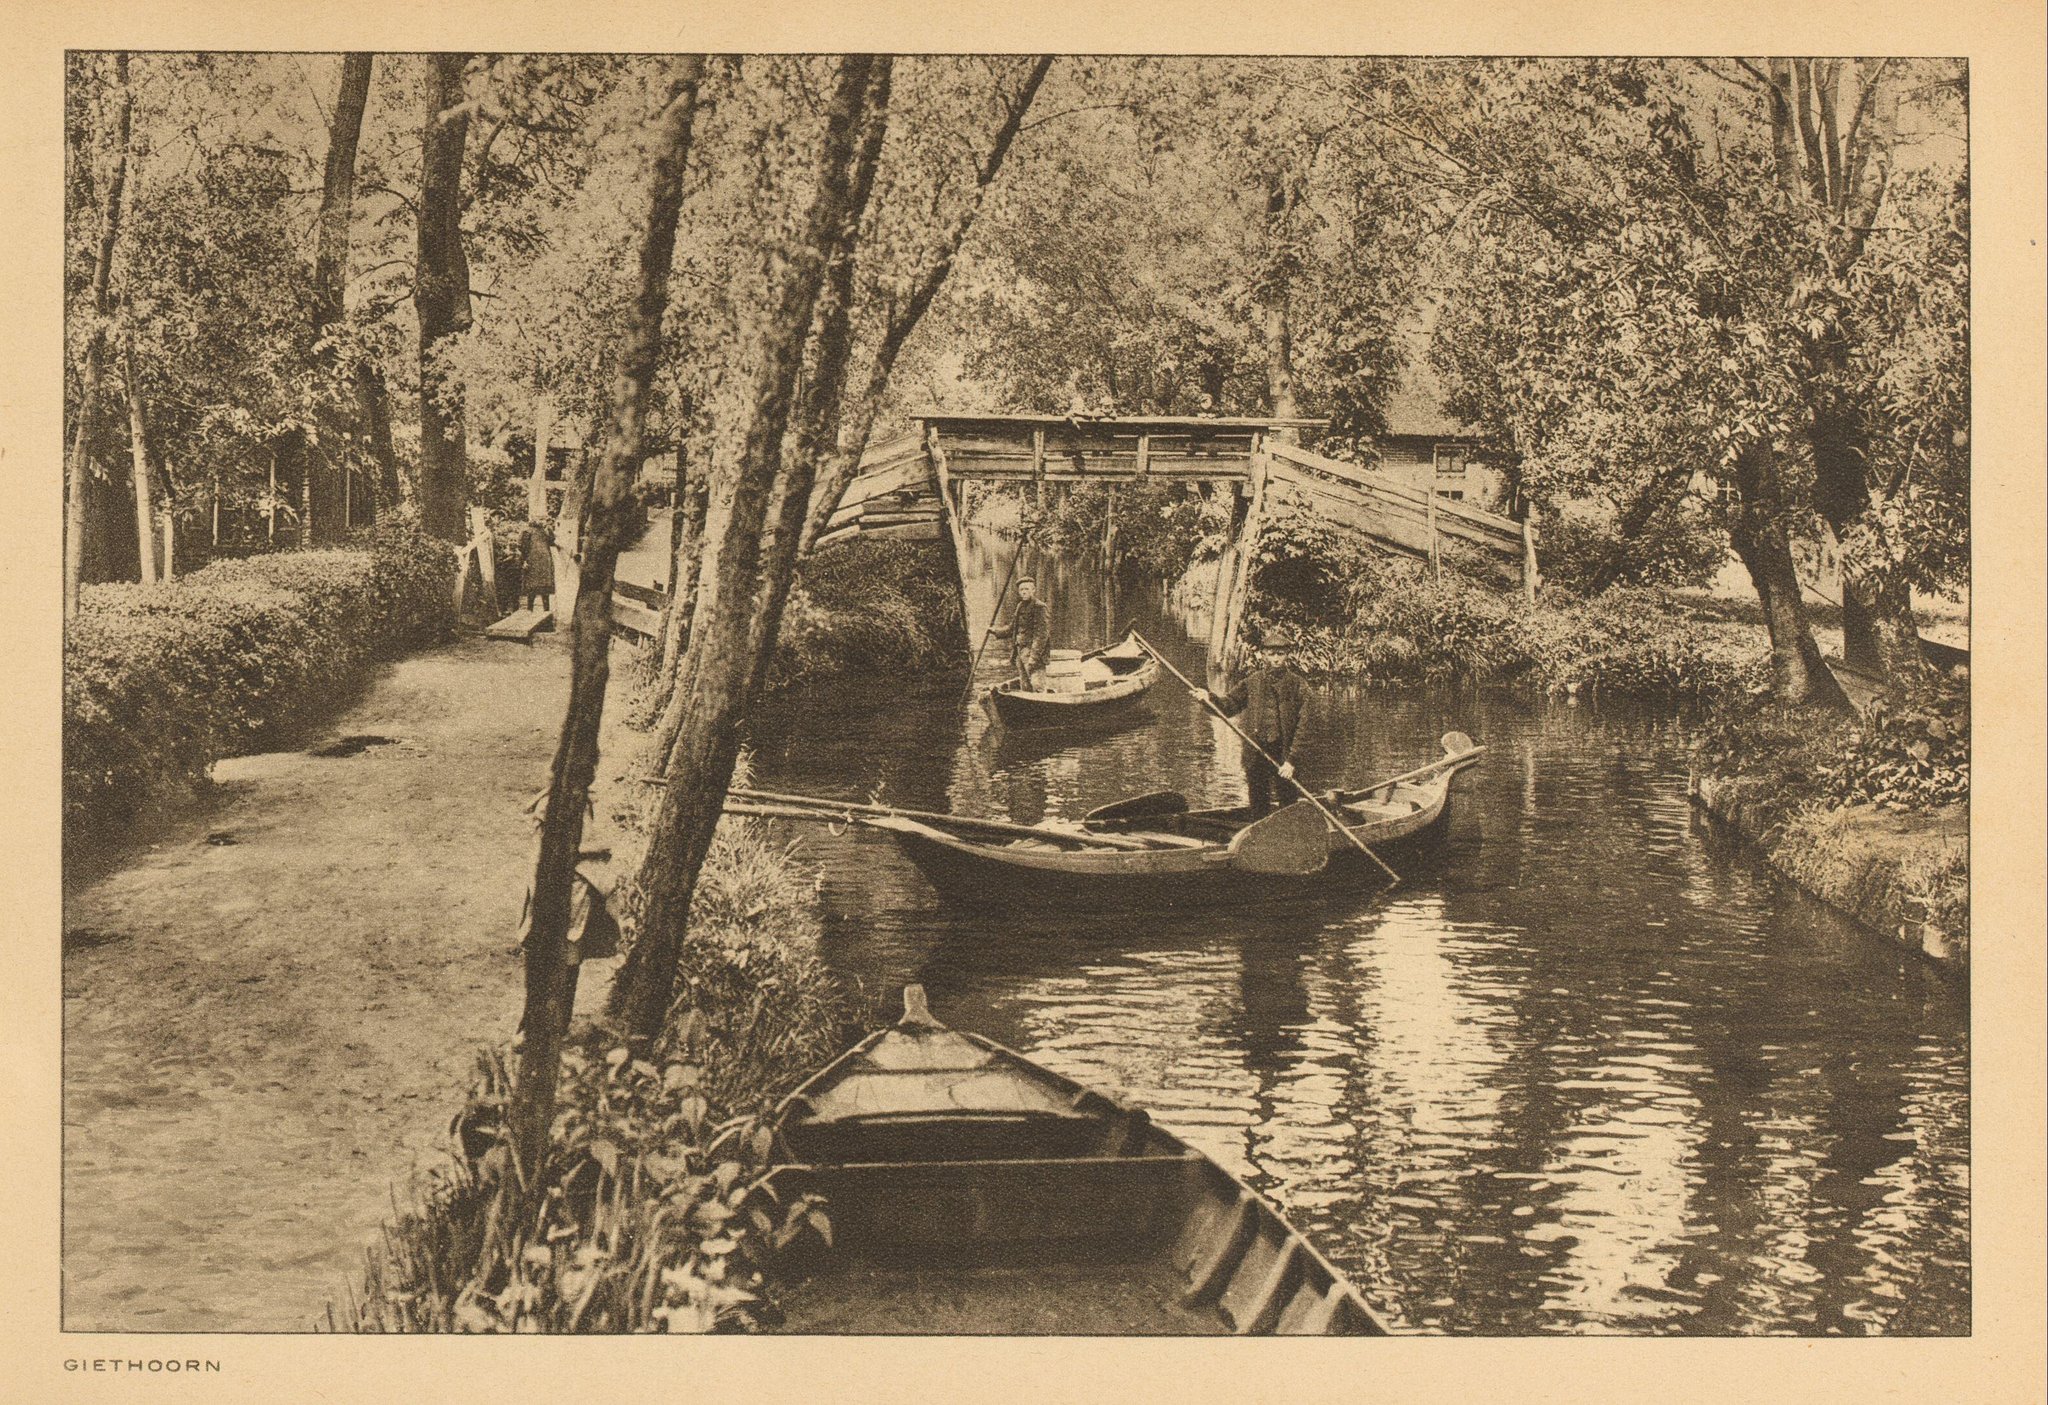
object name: album leaf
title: Giethoorn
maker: Anonymous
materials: paper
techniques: rotogravure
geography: giethoorn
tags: prospect of village, silhouette of village, canals, waters (in city), gondola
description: Deze prent maakt deel uit van een album.